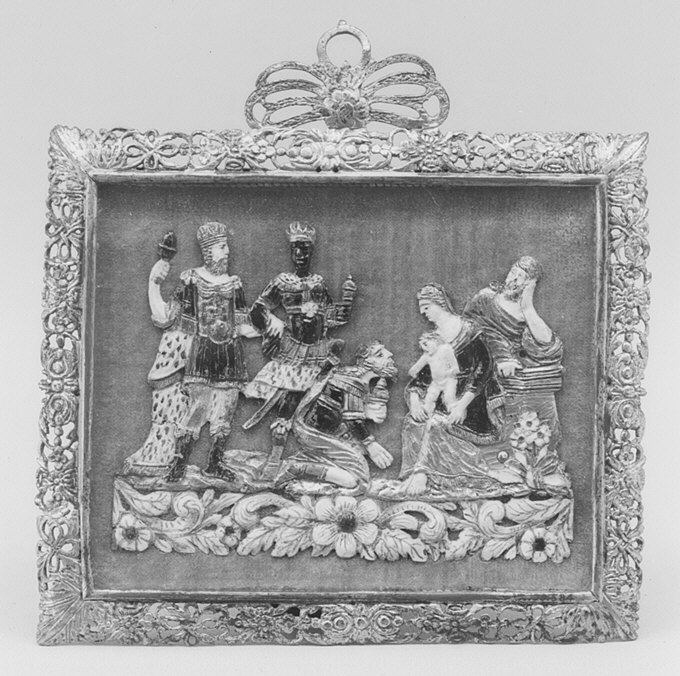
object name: plaque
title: Adoration of the Magi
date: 1601-1700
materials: enamel, gold, velvet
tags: flowers,adoration of the magi